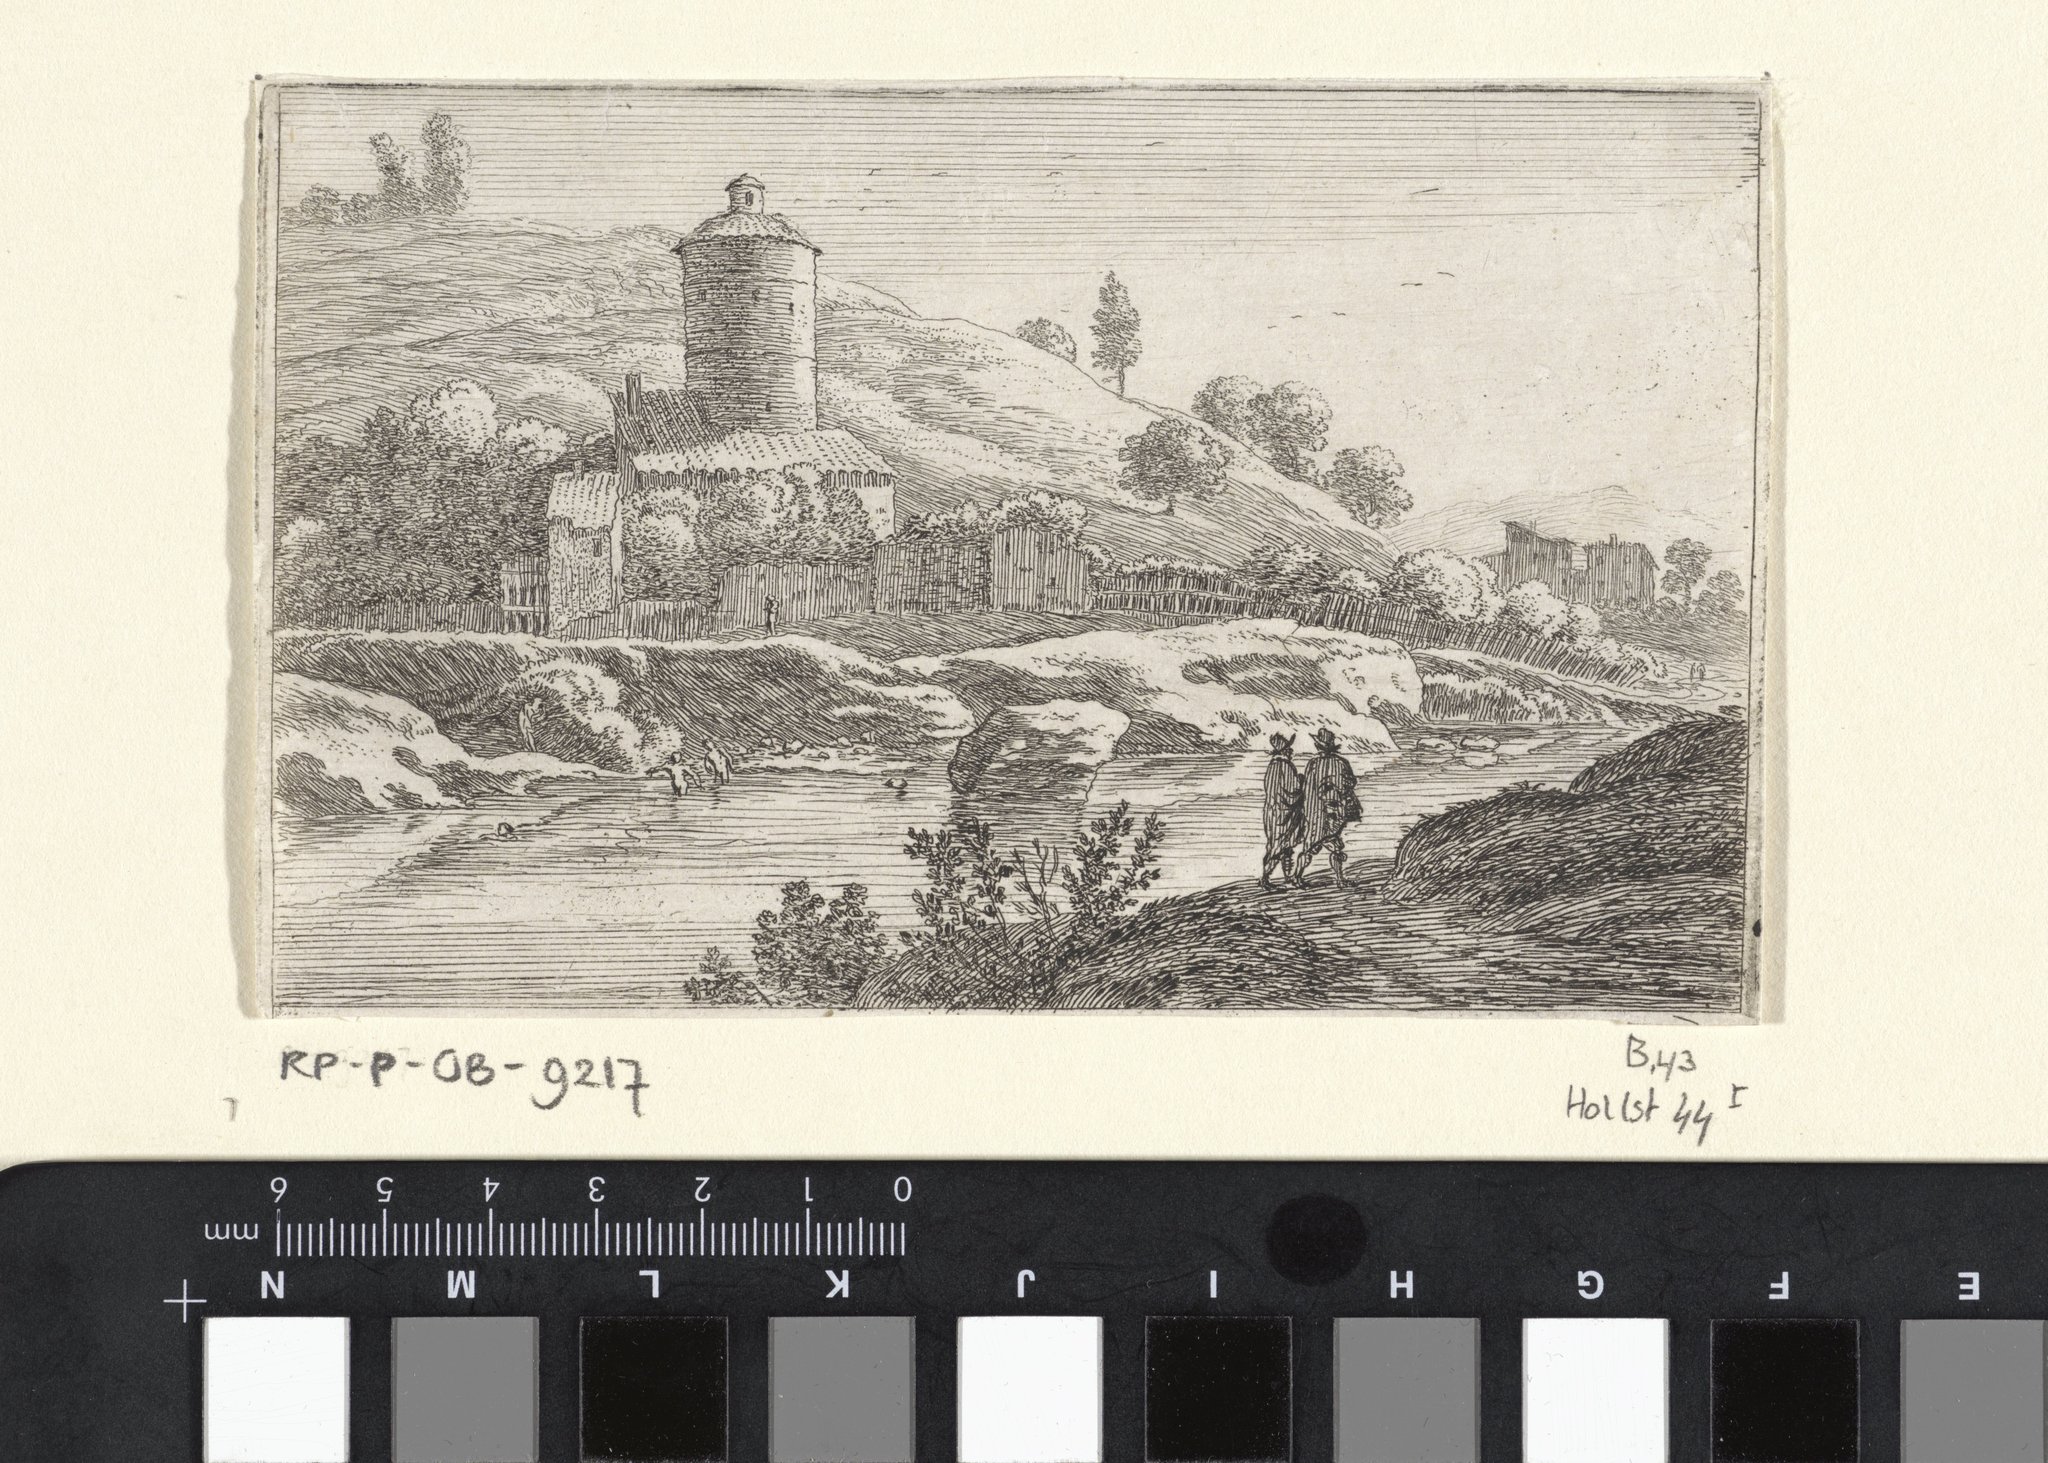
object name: print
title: Titelblad en twaalf gezichten op Rome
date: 1629-1655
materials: paper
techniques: etching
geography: rome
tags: landscapes, river, tower (of house or building), country-house, rome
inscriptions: collector's mark: Lugt 240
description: Op de oever van de Tiber met twee badende figuren staat een omheind gebouw met een ronde toren. Op het pad aan de overzijde van de rivier lopen twee wandelaars.